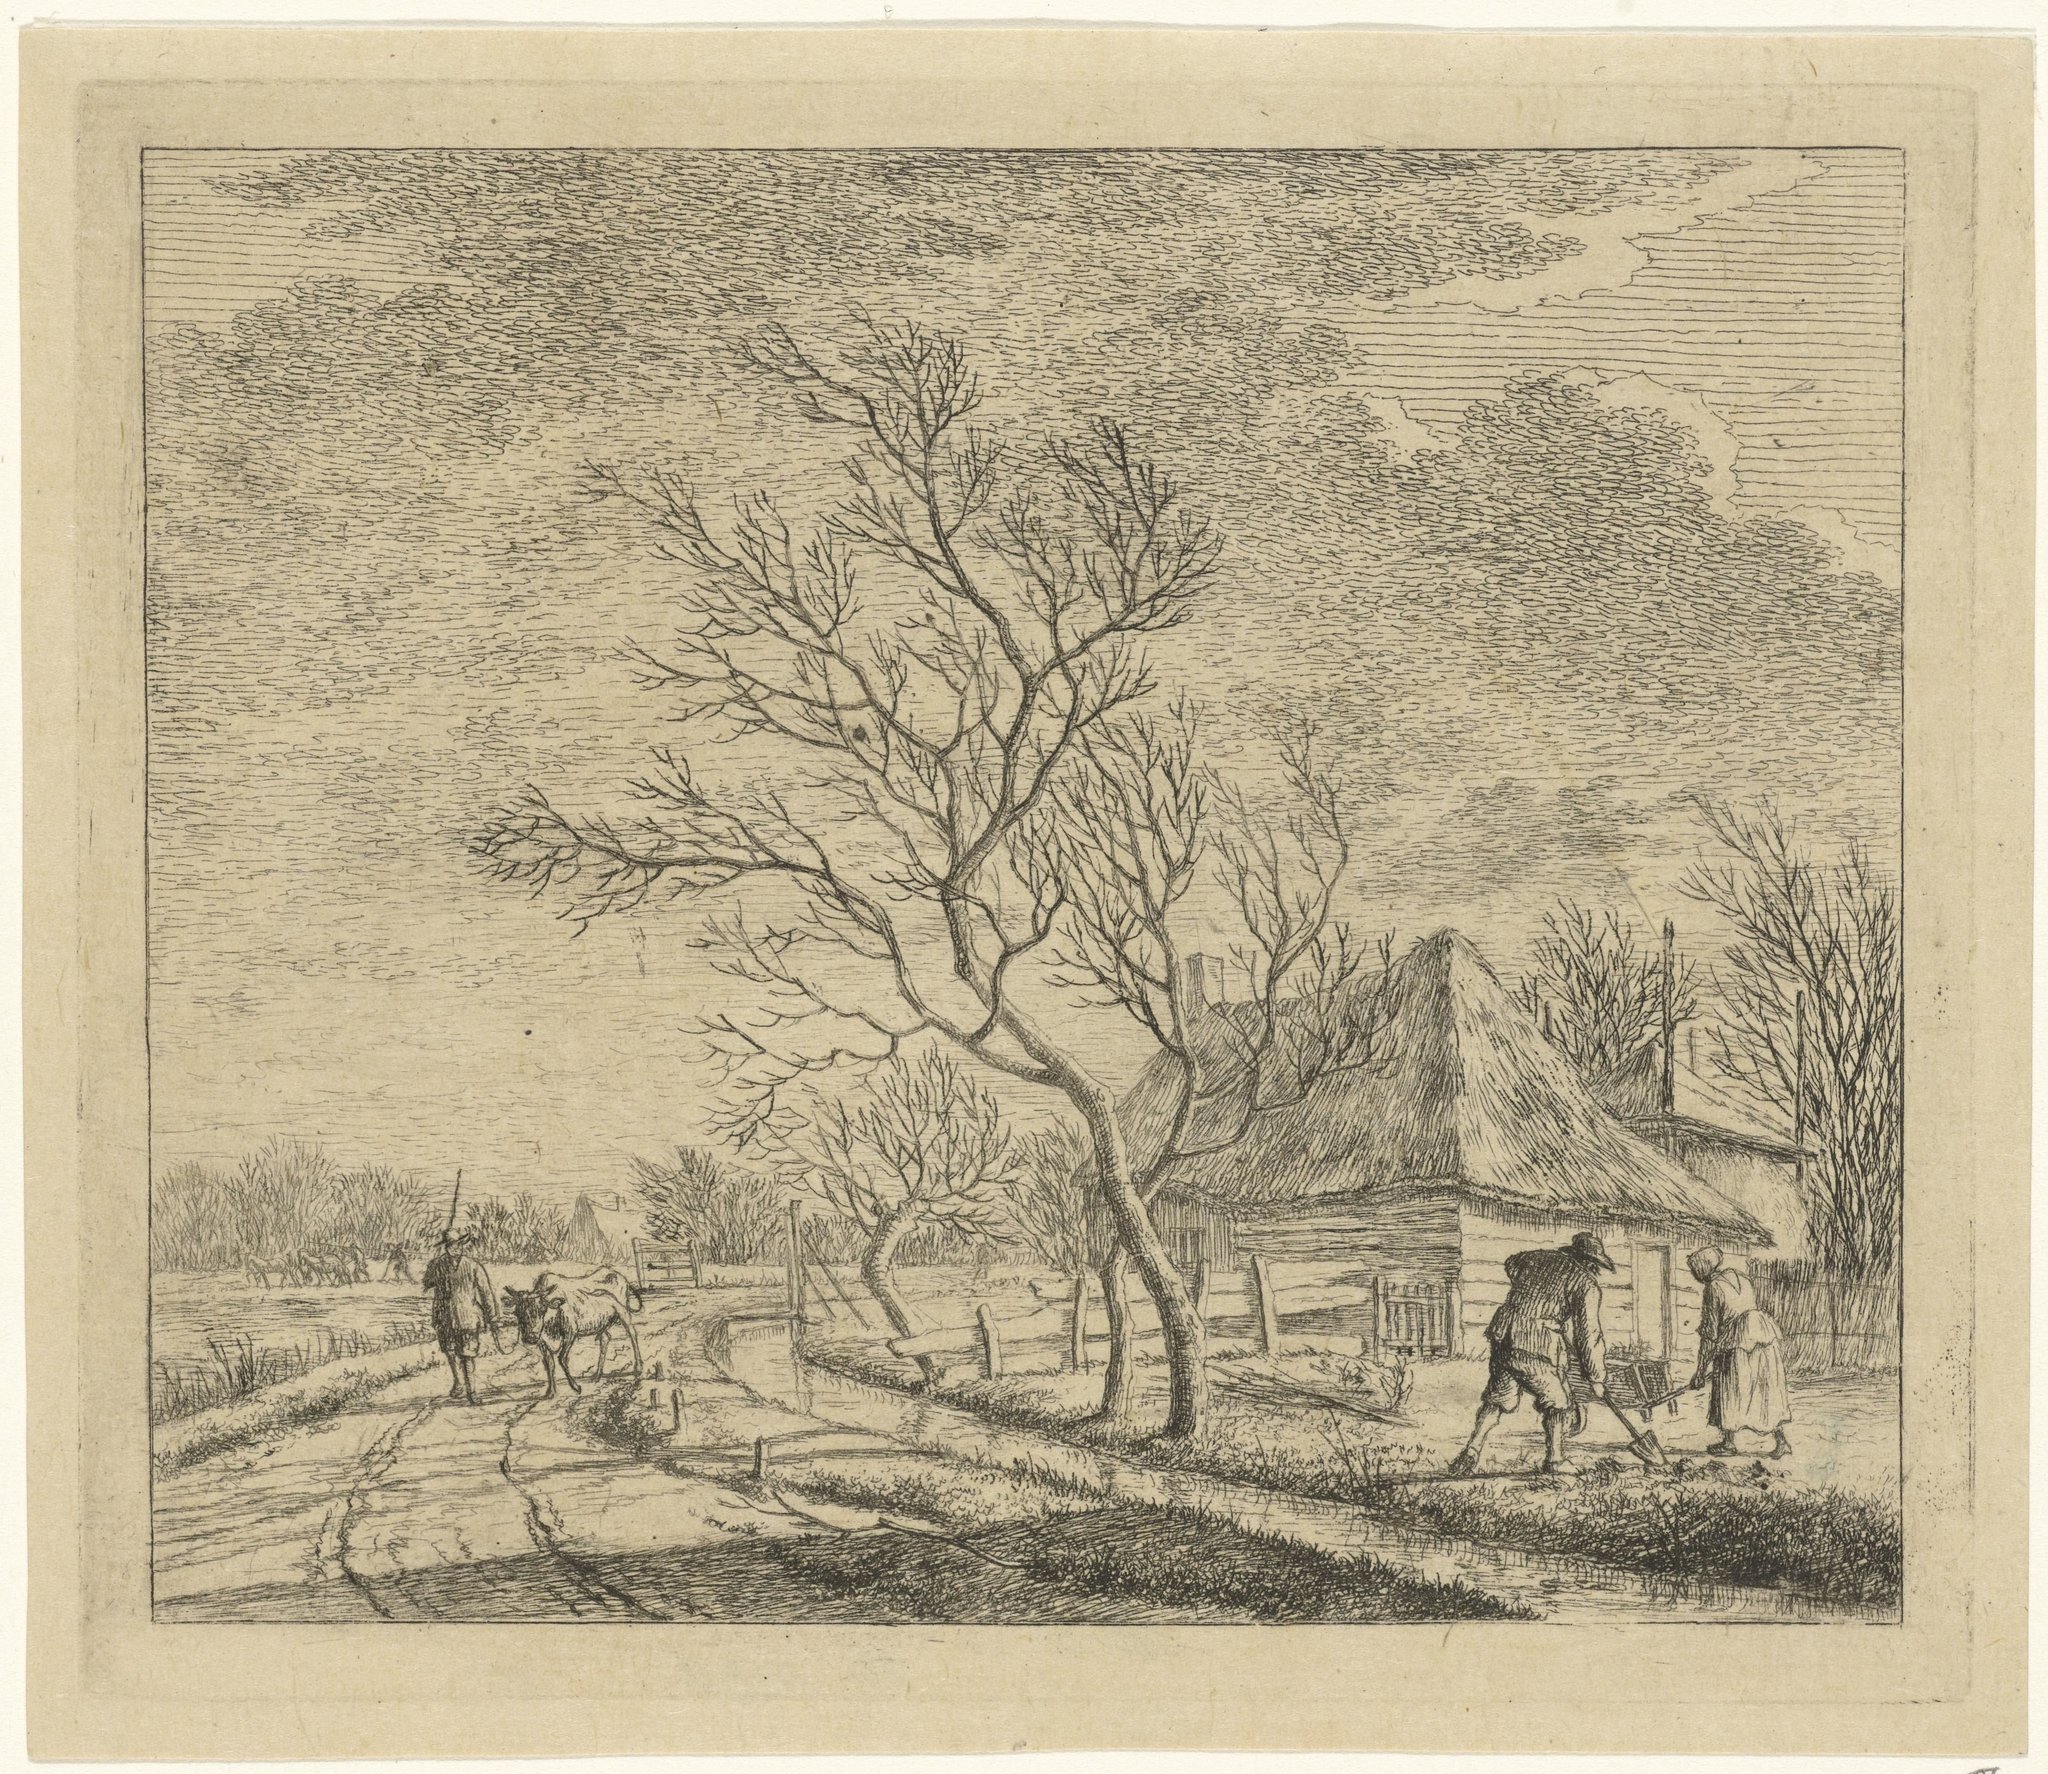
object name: print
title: De gecouleurde Teekeningen van de 12 Maanden (...)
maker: johannes janson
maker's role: draughtsman, painter, print maker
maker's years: 1729-1784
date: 1783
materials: paper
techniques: etching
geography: leiden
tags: landscape symbolizing march, farmers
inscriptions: collector's mark: Lugt 240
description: Landschap met boerderij, boer met schep en boerin met kruiwagen, aan het werk op hun land. Links een pad met een man met koe. Links op de achtergrond boeren en paarden op een akker. Vierde prent uit een serie van dertien met maanden.